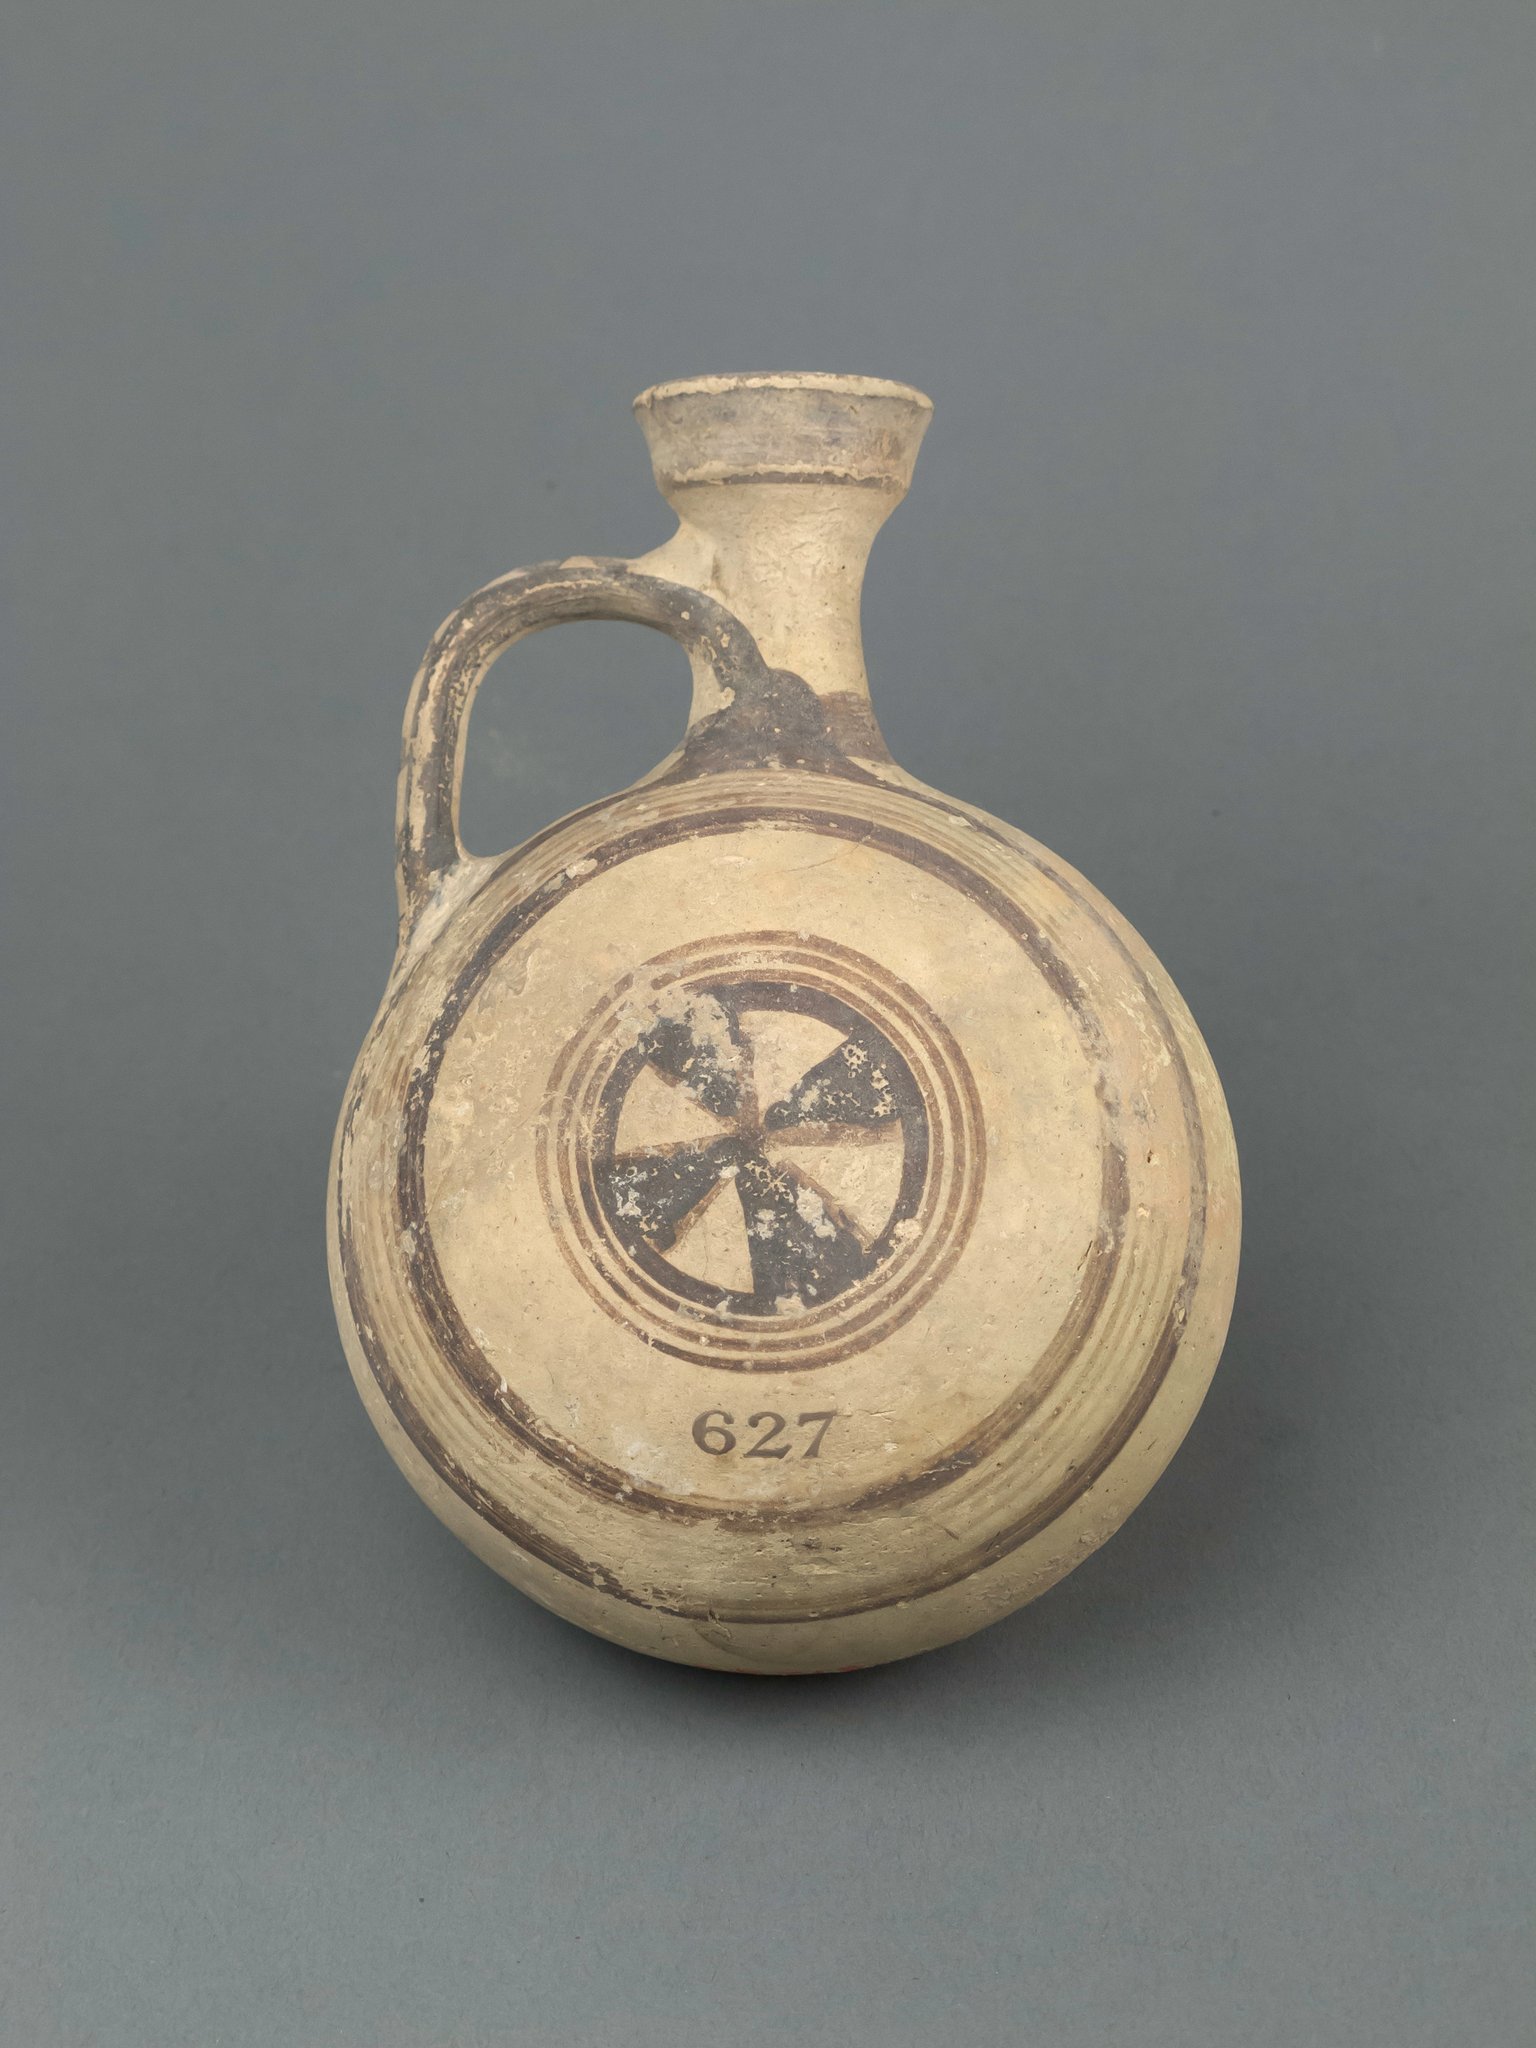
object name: juglet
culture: cypriot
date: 1050-950 BCE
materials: terracotta